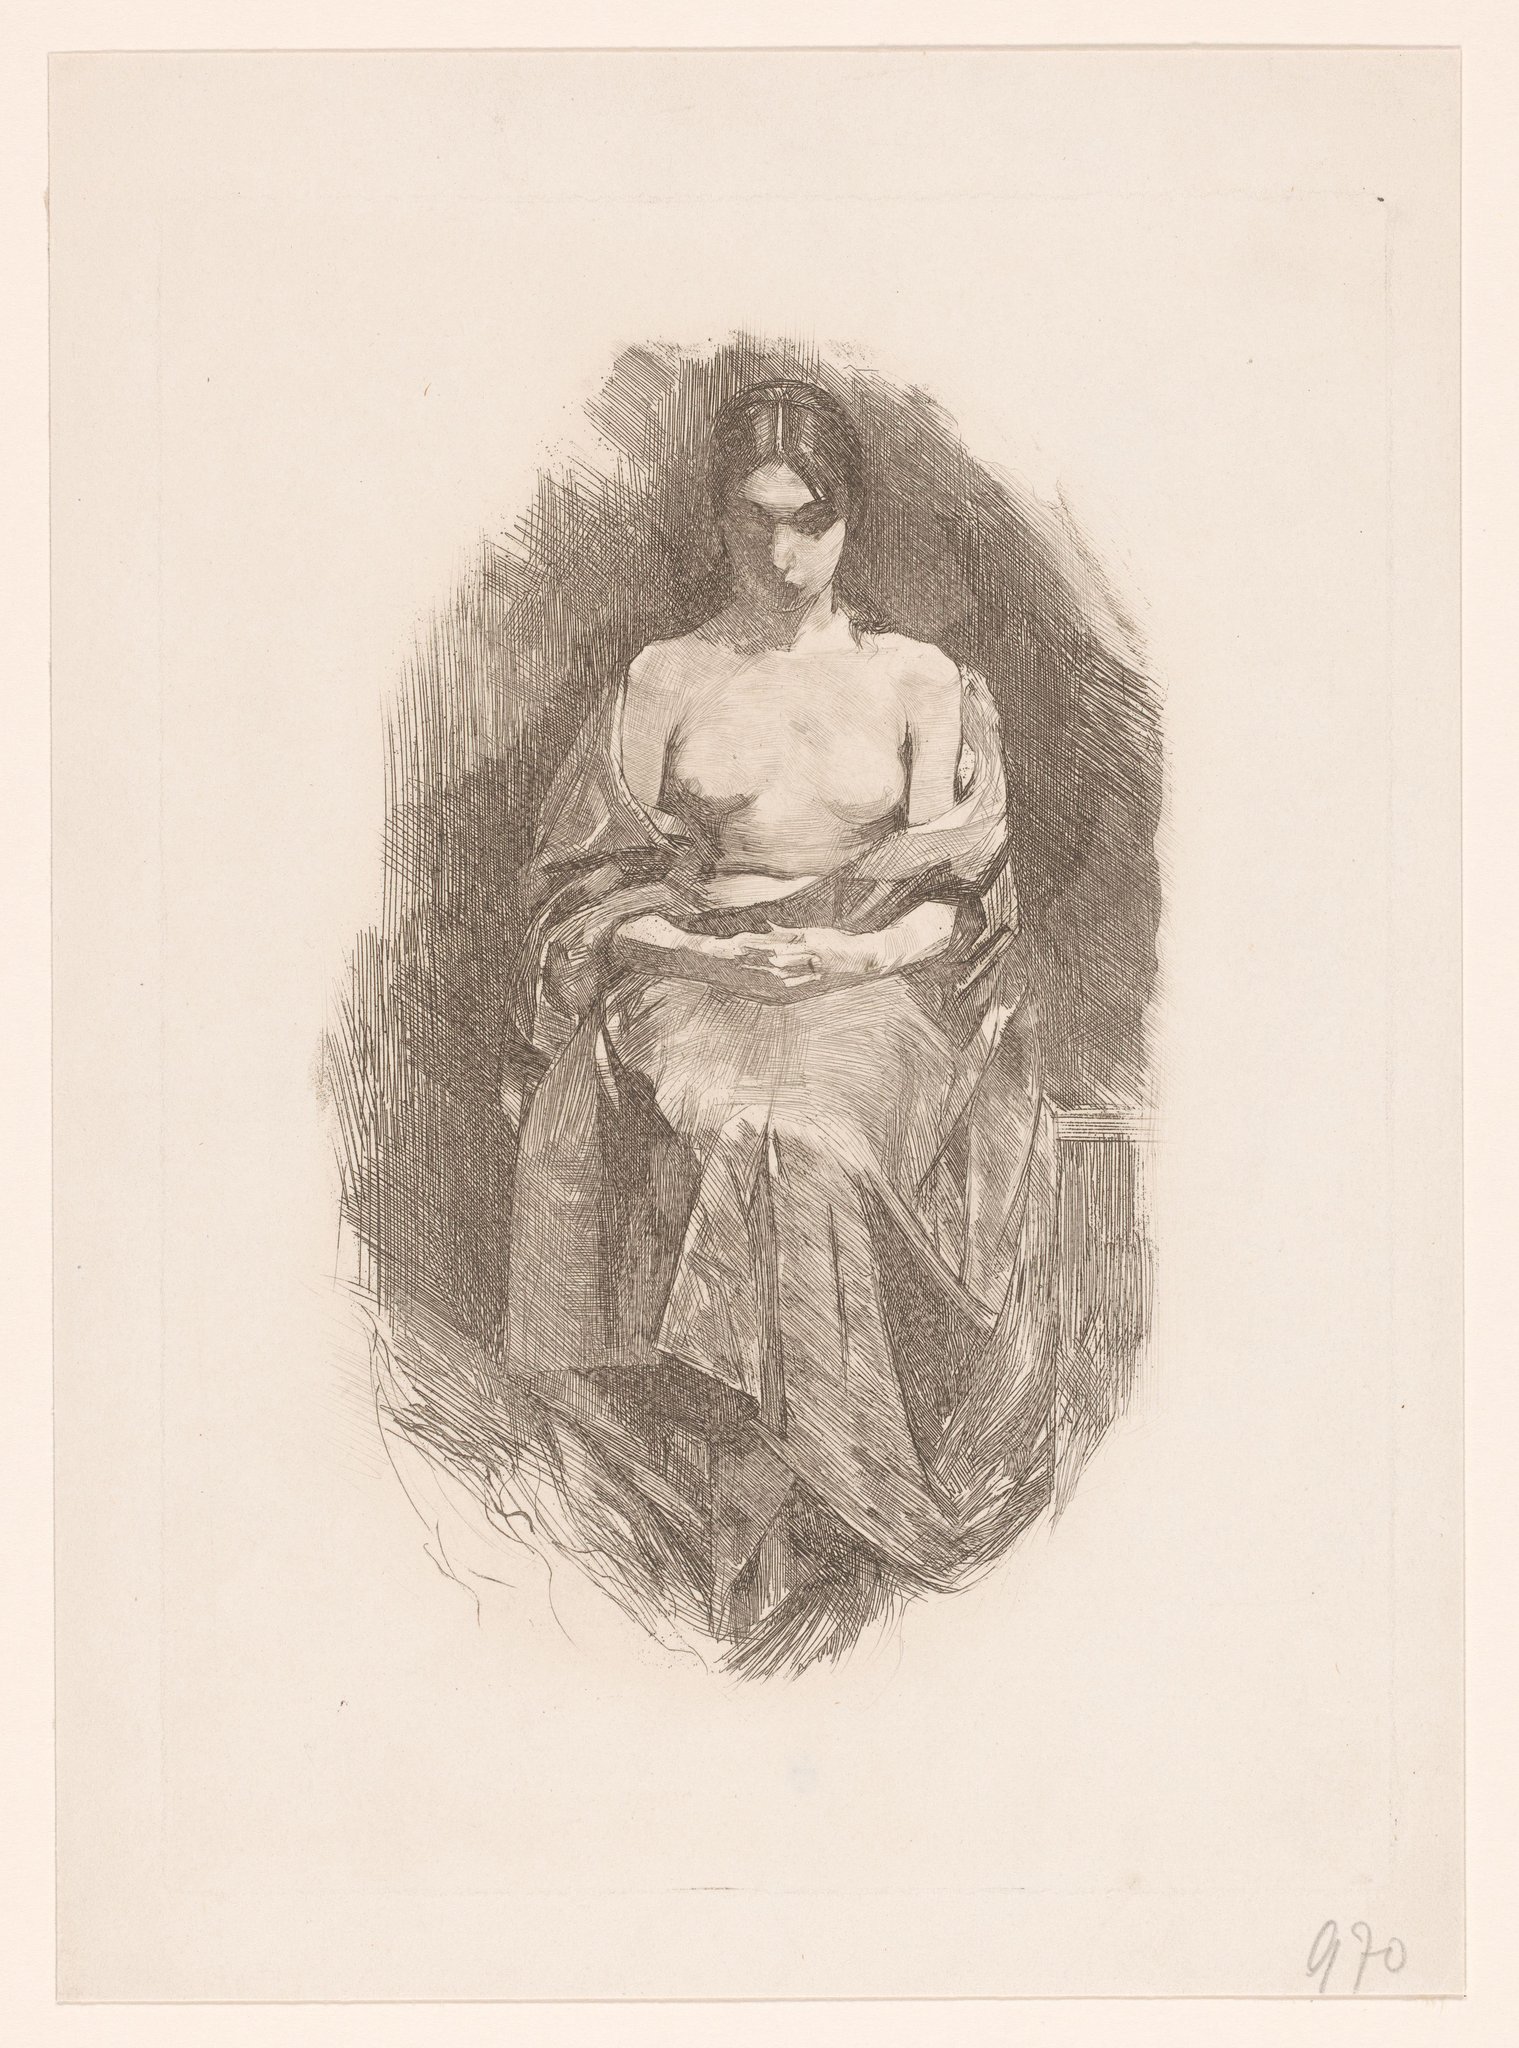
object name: print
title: Zittende vrouw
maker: nicolaas van der waay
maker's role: draughtsman, painter, print maker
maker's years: 1855-1936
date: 1865-1936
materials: paper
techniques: drypoint, etching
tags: (showing oneself) undressed, quasi-nude, sitting figure - aa - female human figure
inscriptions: collector's mark: Lugt 2760, collector's mark: Lugt 2228